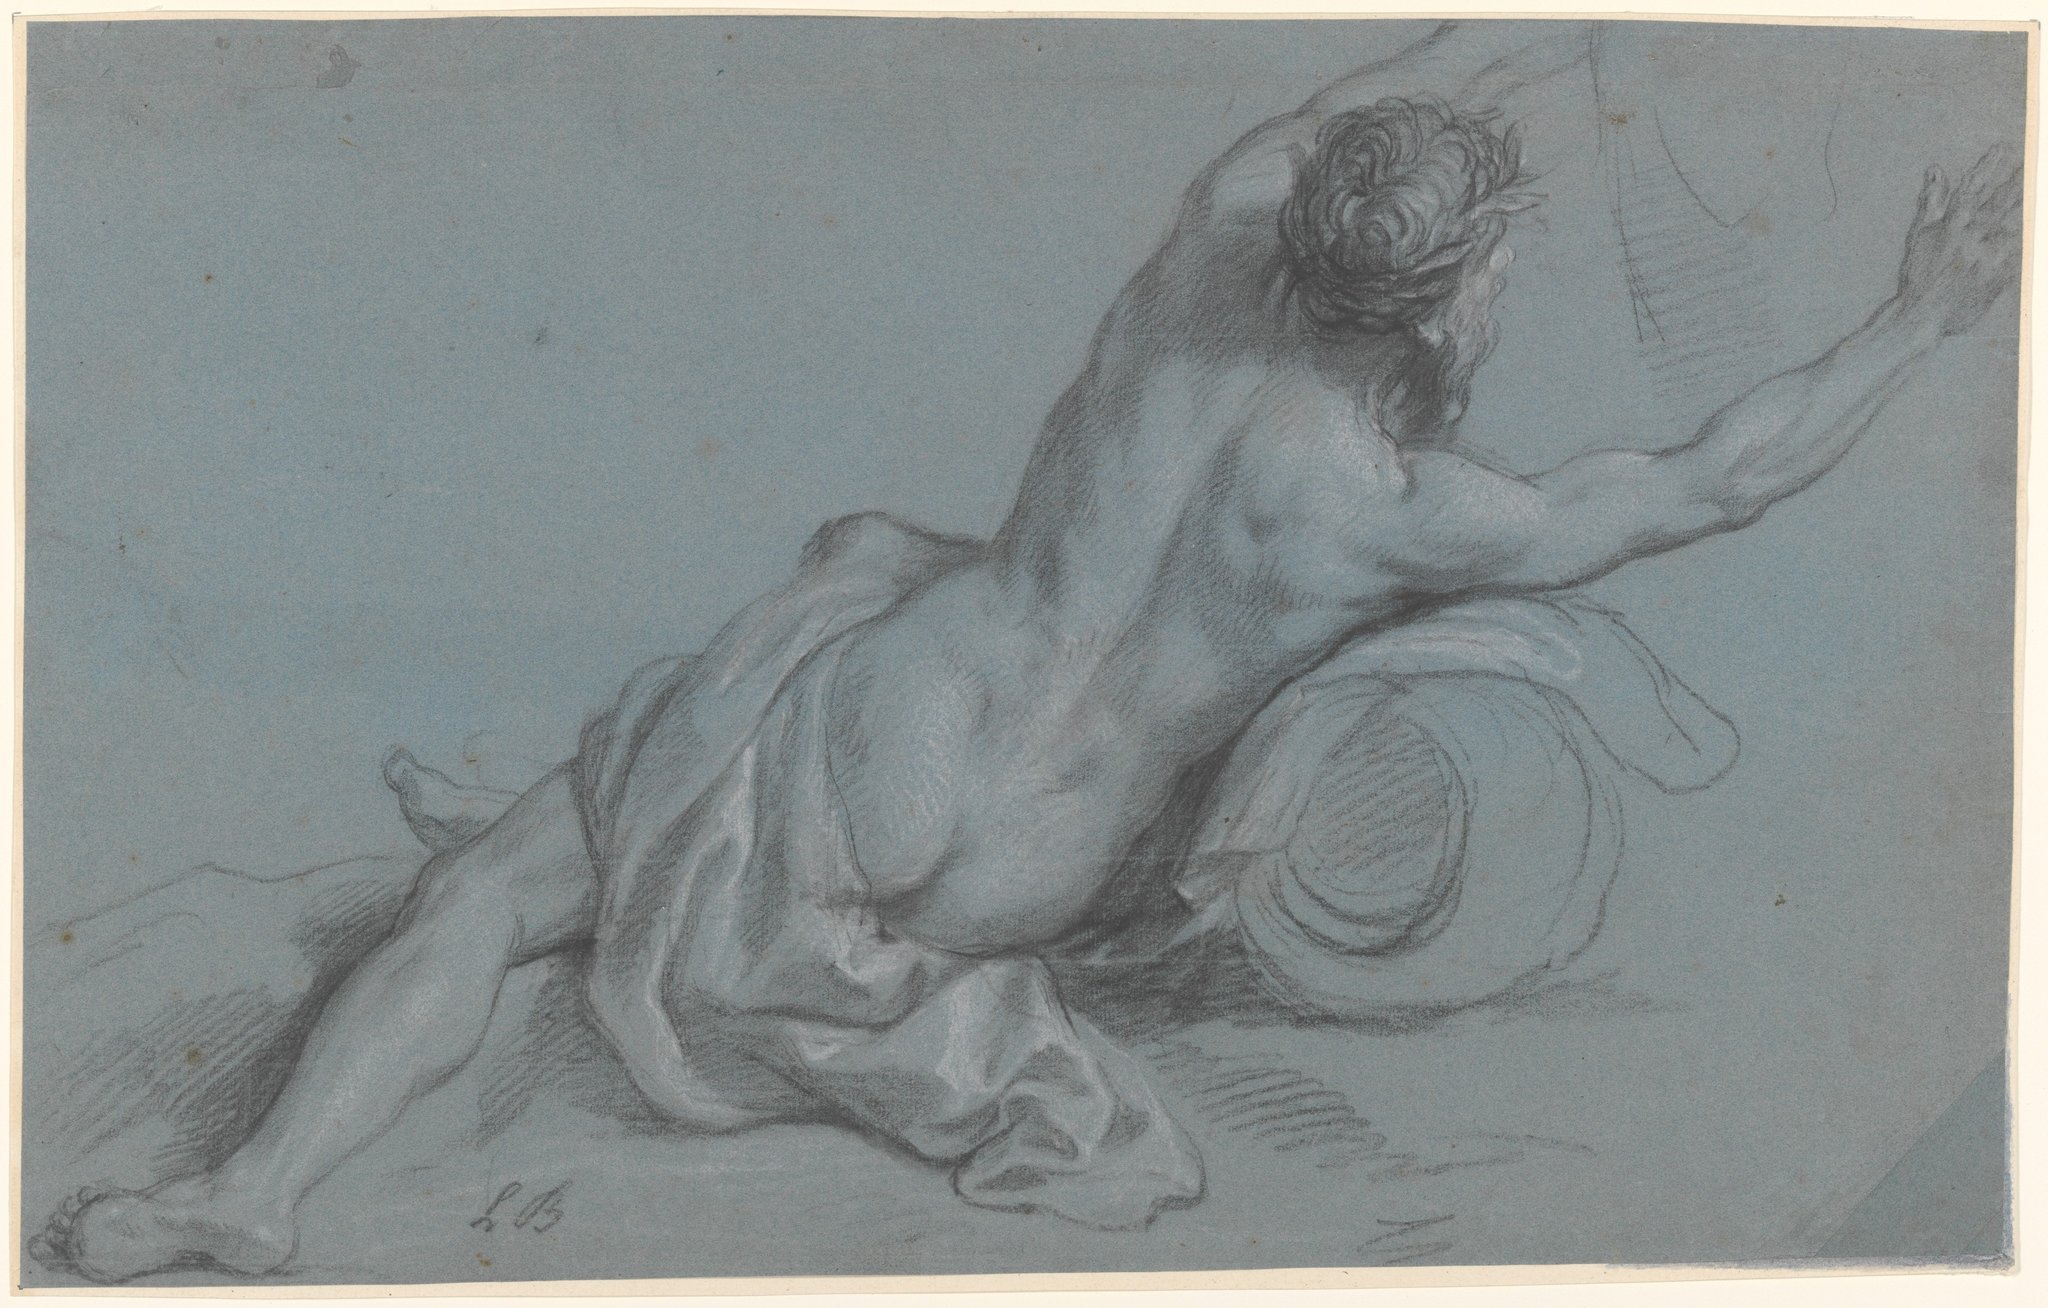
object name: drawing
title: Reclining River God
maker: louis de boullogne the younger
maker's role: artist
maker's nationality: french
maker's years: 1654-1733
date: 1694-1715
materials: chalk, paper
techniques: heightening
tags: male nudes